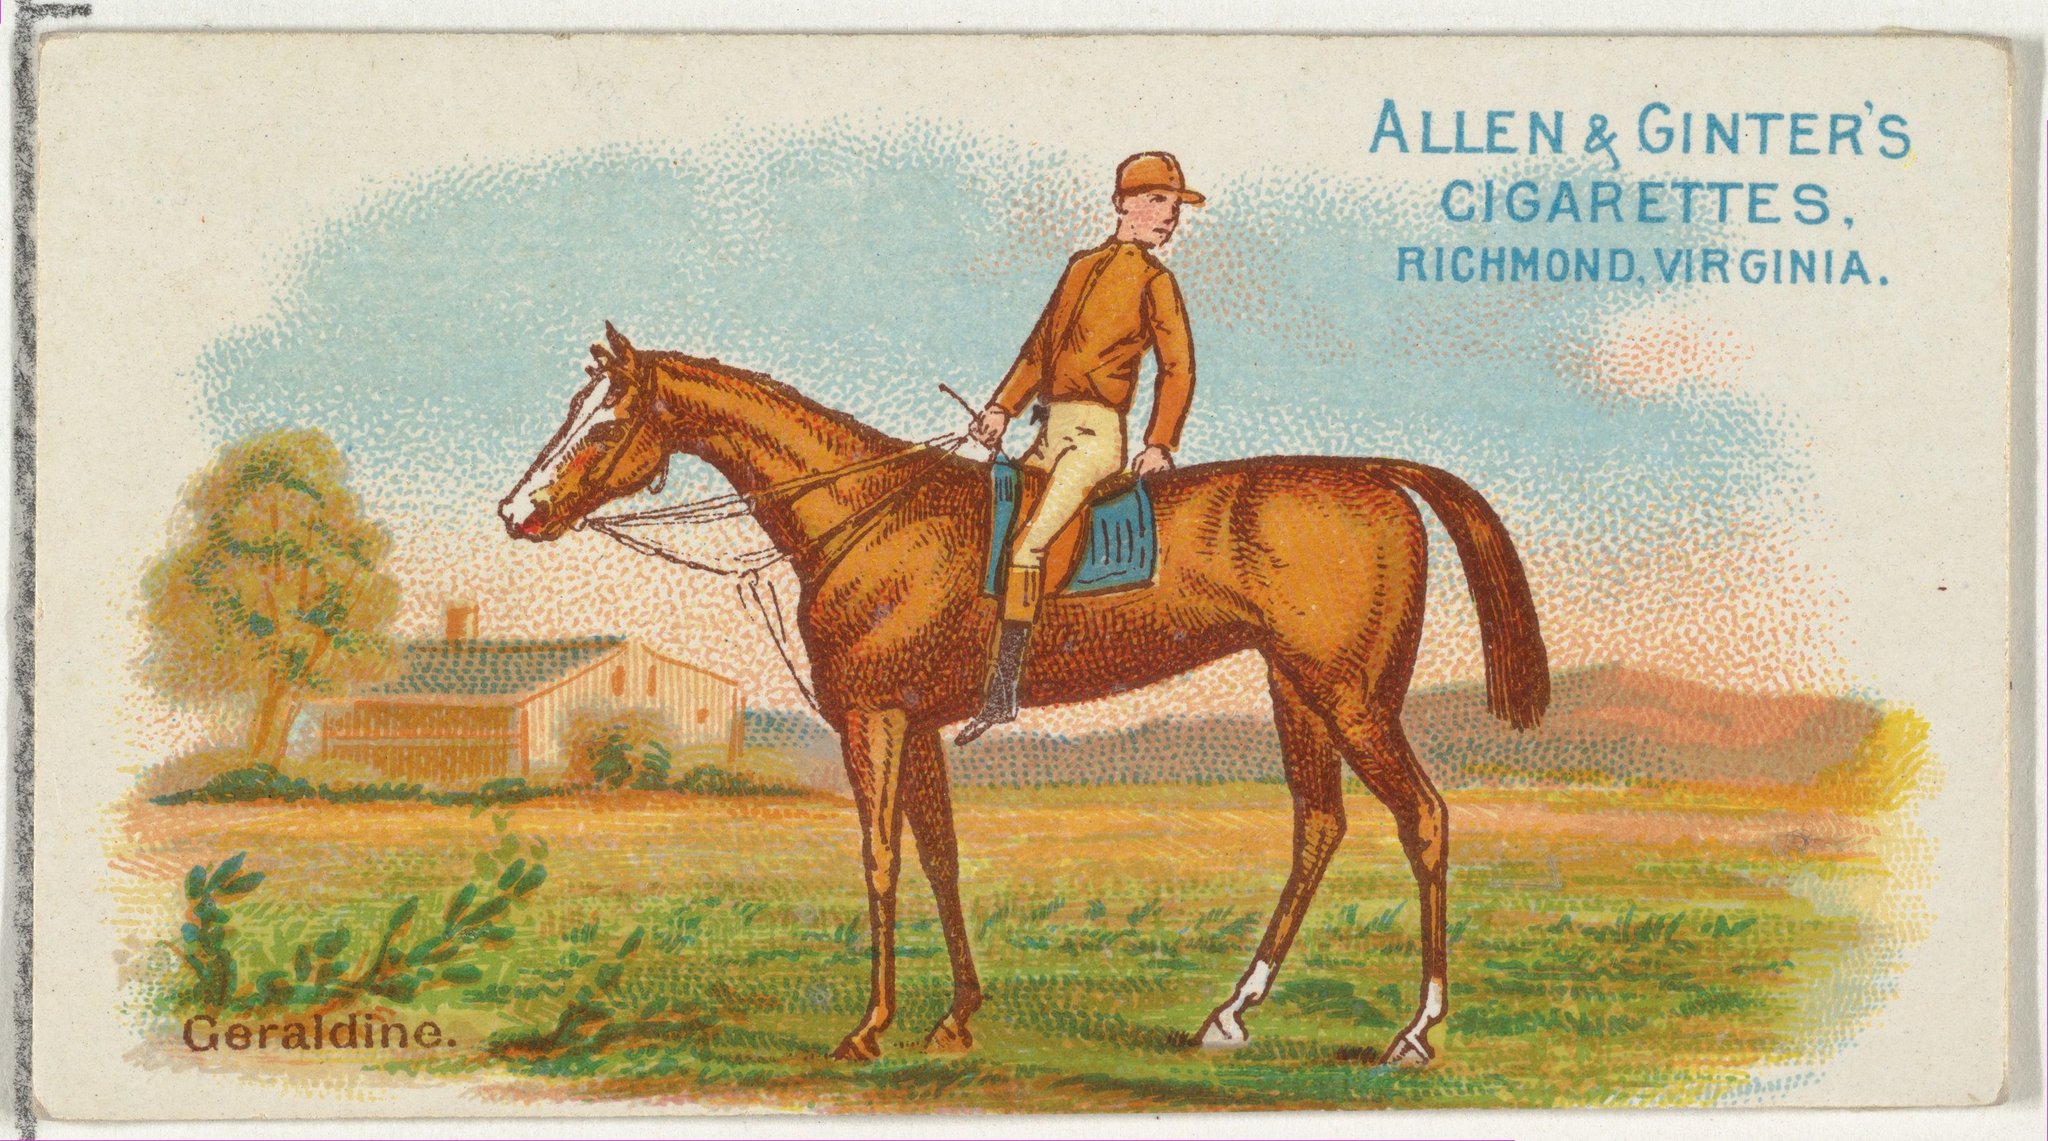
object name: print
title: Geraldine, from The World's Racers series (N32) for Allen & Ginter Cigarettes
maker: allen & ginter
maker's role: publisher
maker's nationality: american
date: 1888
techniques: color lithograph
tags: men,horses,jockeys